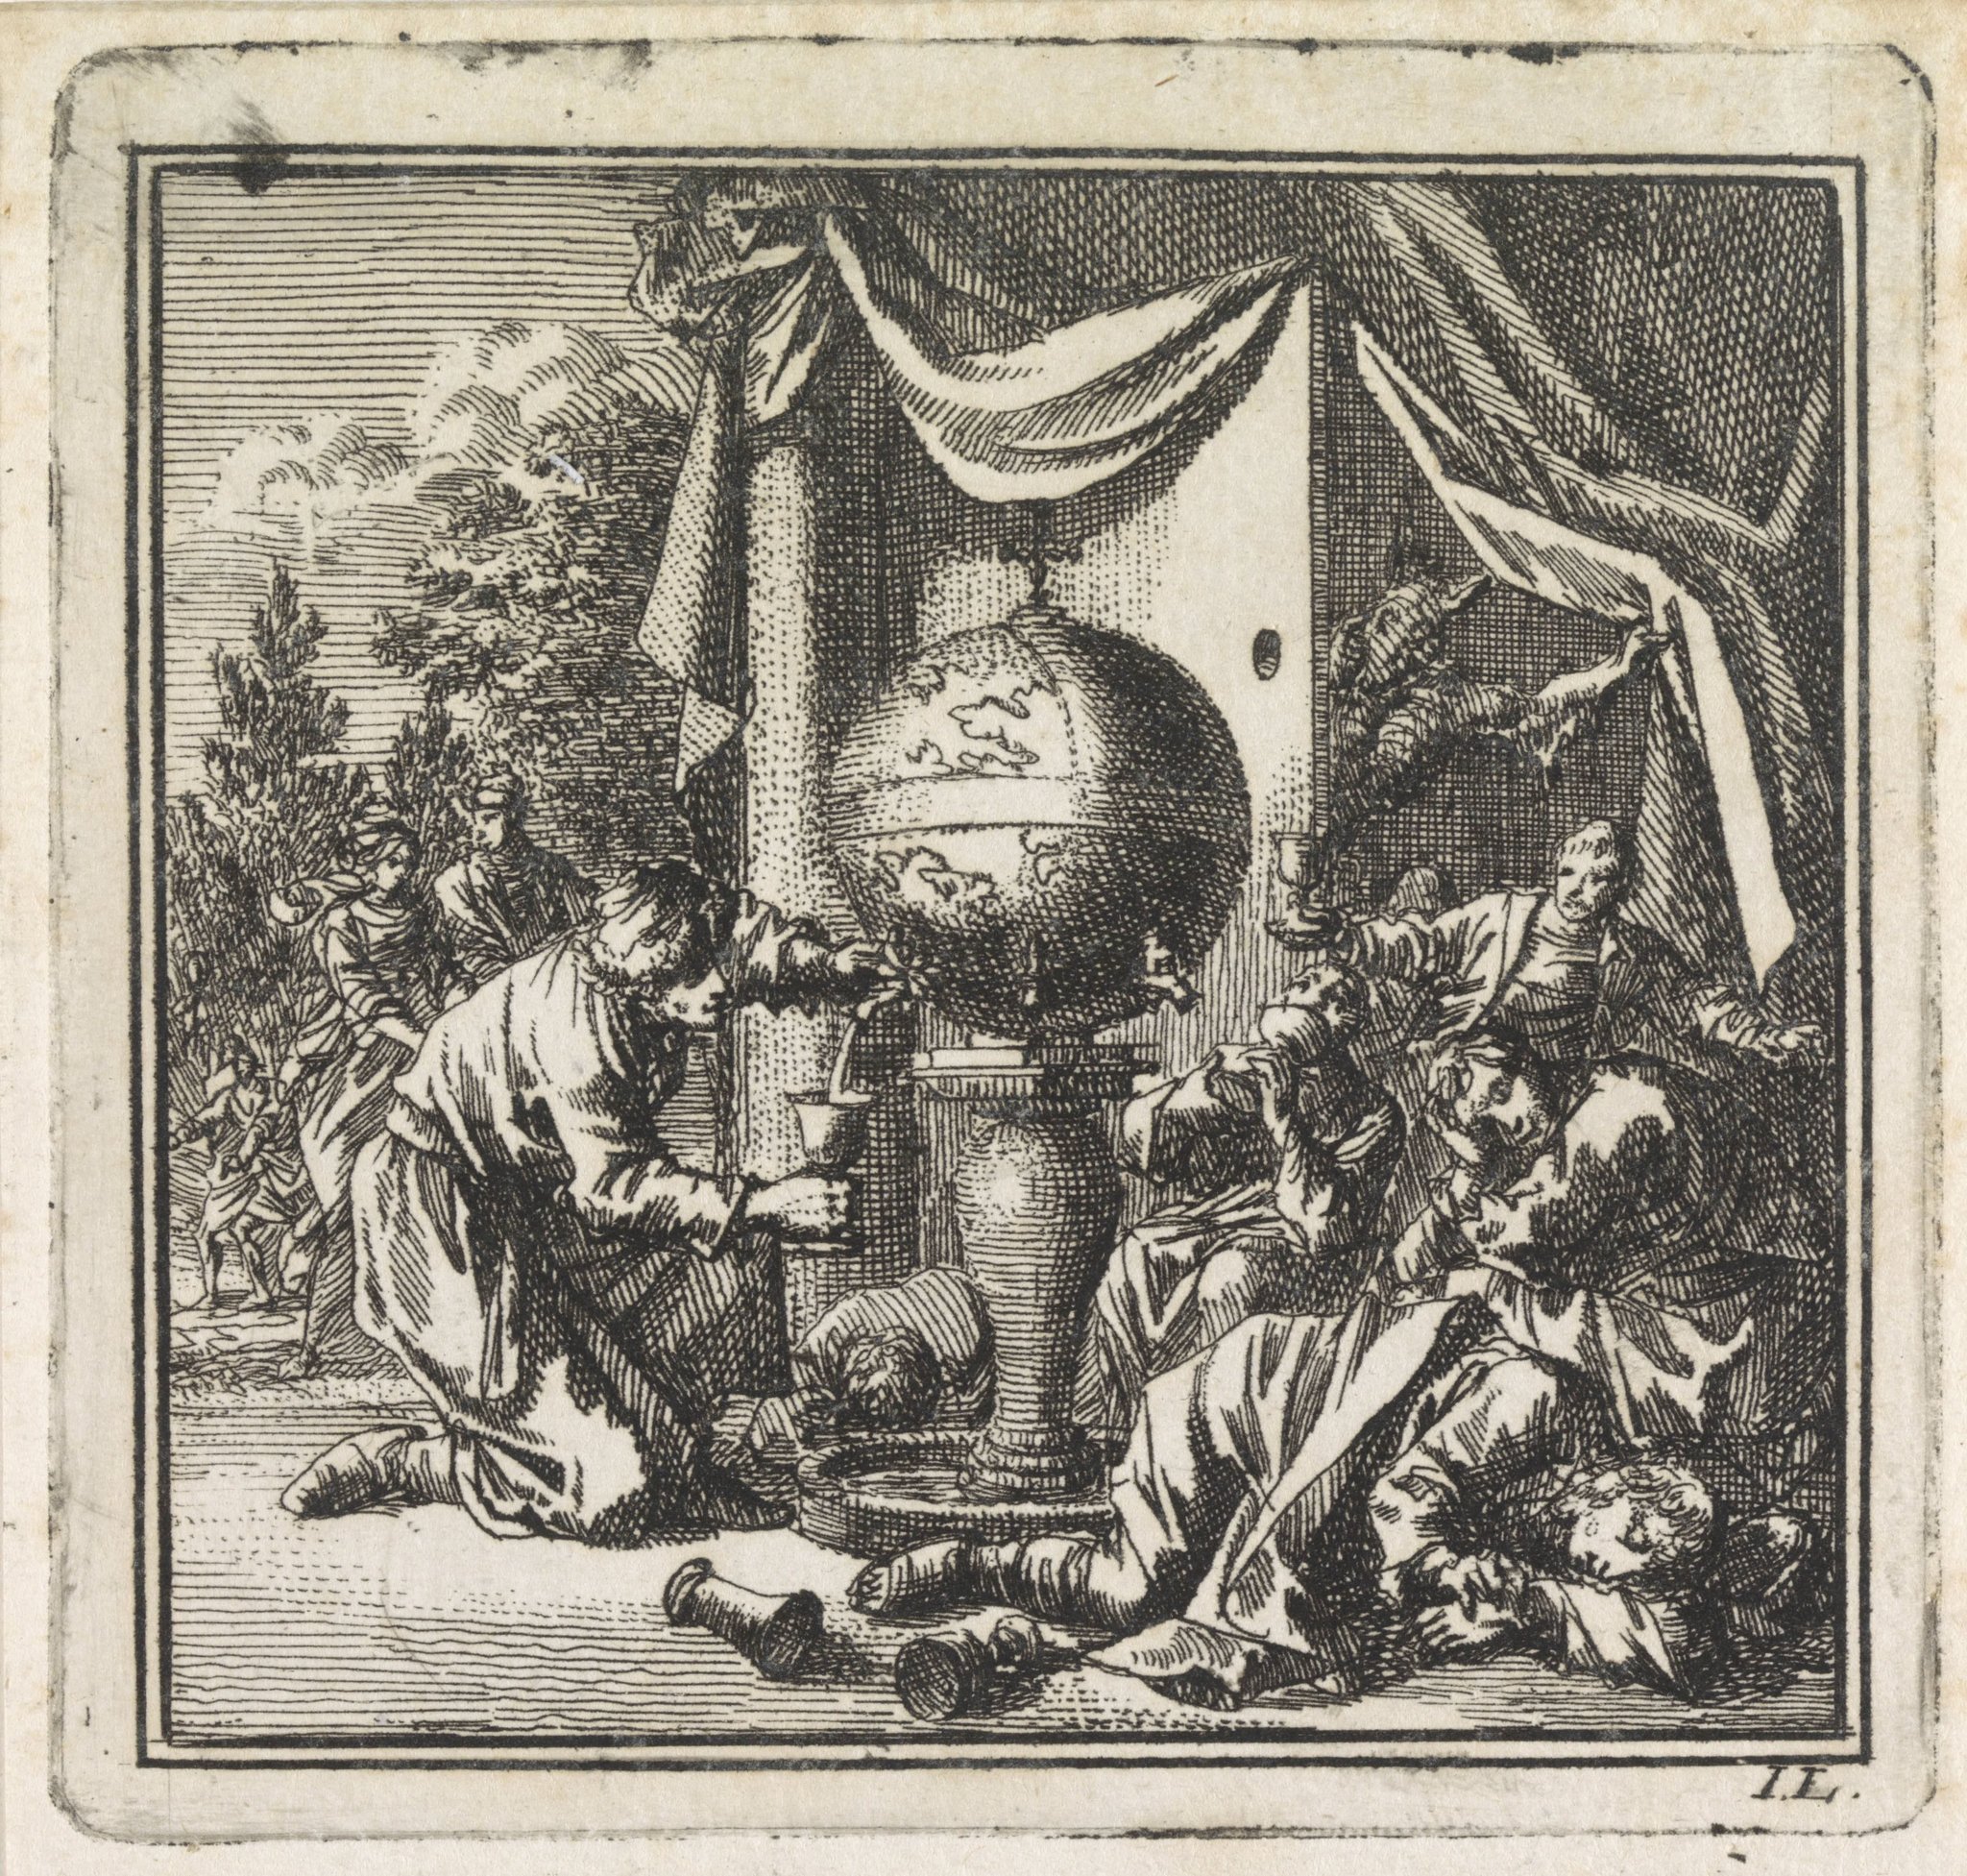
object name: print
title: De Dronkenschap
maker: jan luyken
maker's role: draughtsman, print maker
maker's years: 1649-1712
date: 1710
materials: paper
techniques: etching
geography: amsterdam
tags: earth, world as celestial body, alcoholic drinks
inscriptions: collector's mark: Lugt 2228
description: Illustratie uit: Luyken, Jan. De onwaardige wereld, vertoond in vyftig zinnebeelden, met godlyke spreuken en stichtelyke verzen. Amsterdam: Pieter Arentsz. II (wed.) en Cornelis van der Sys, 1710, p. 124.